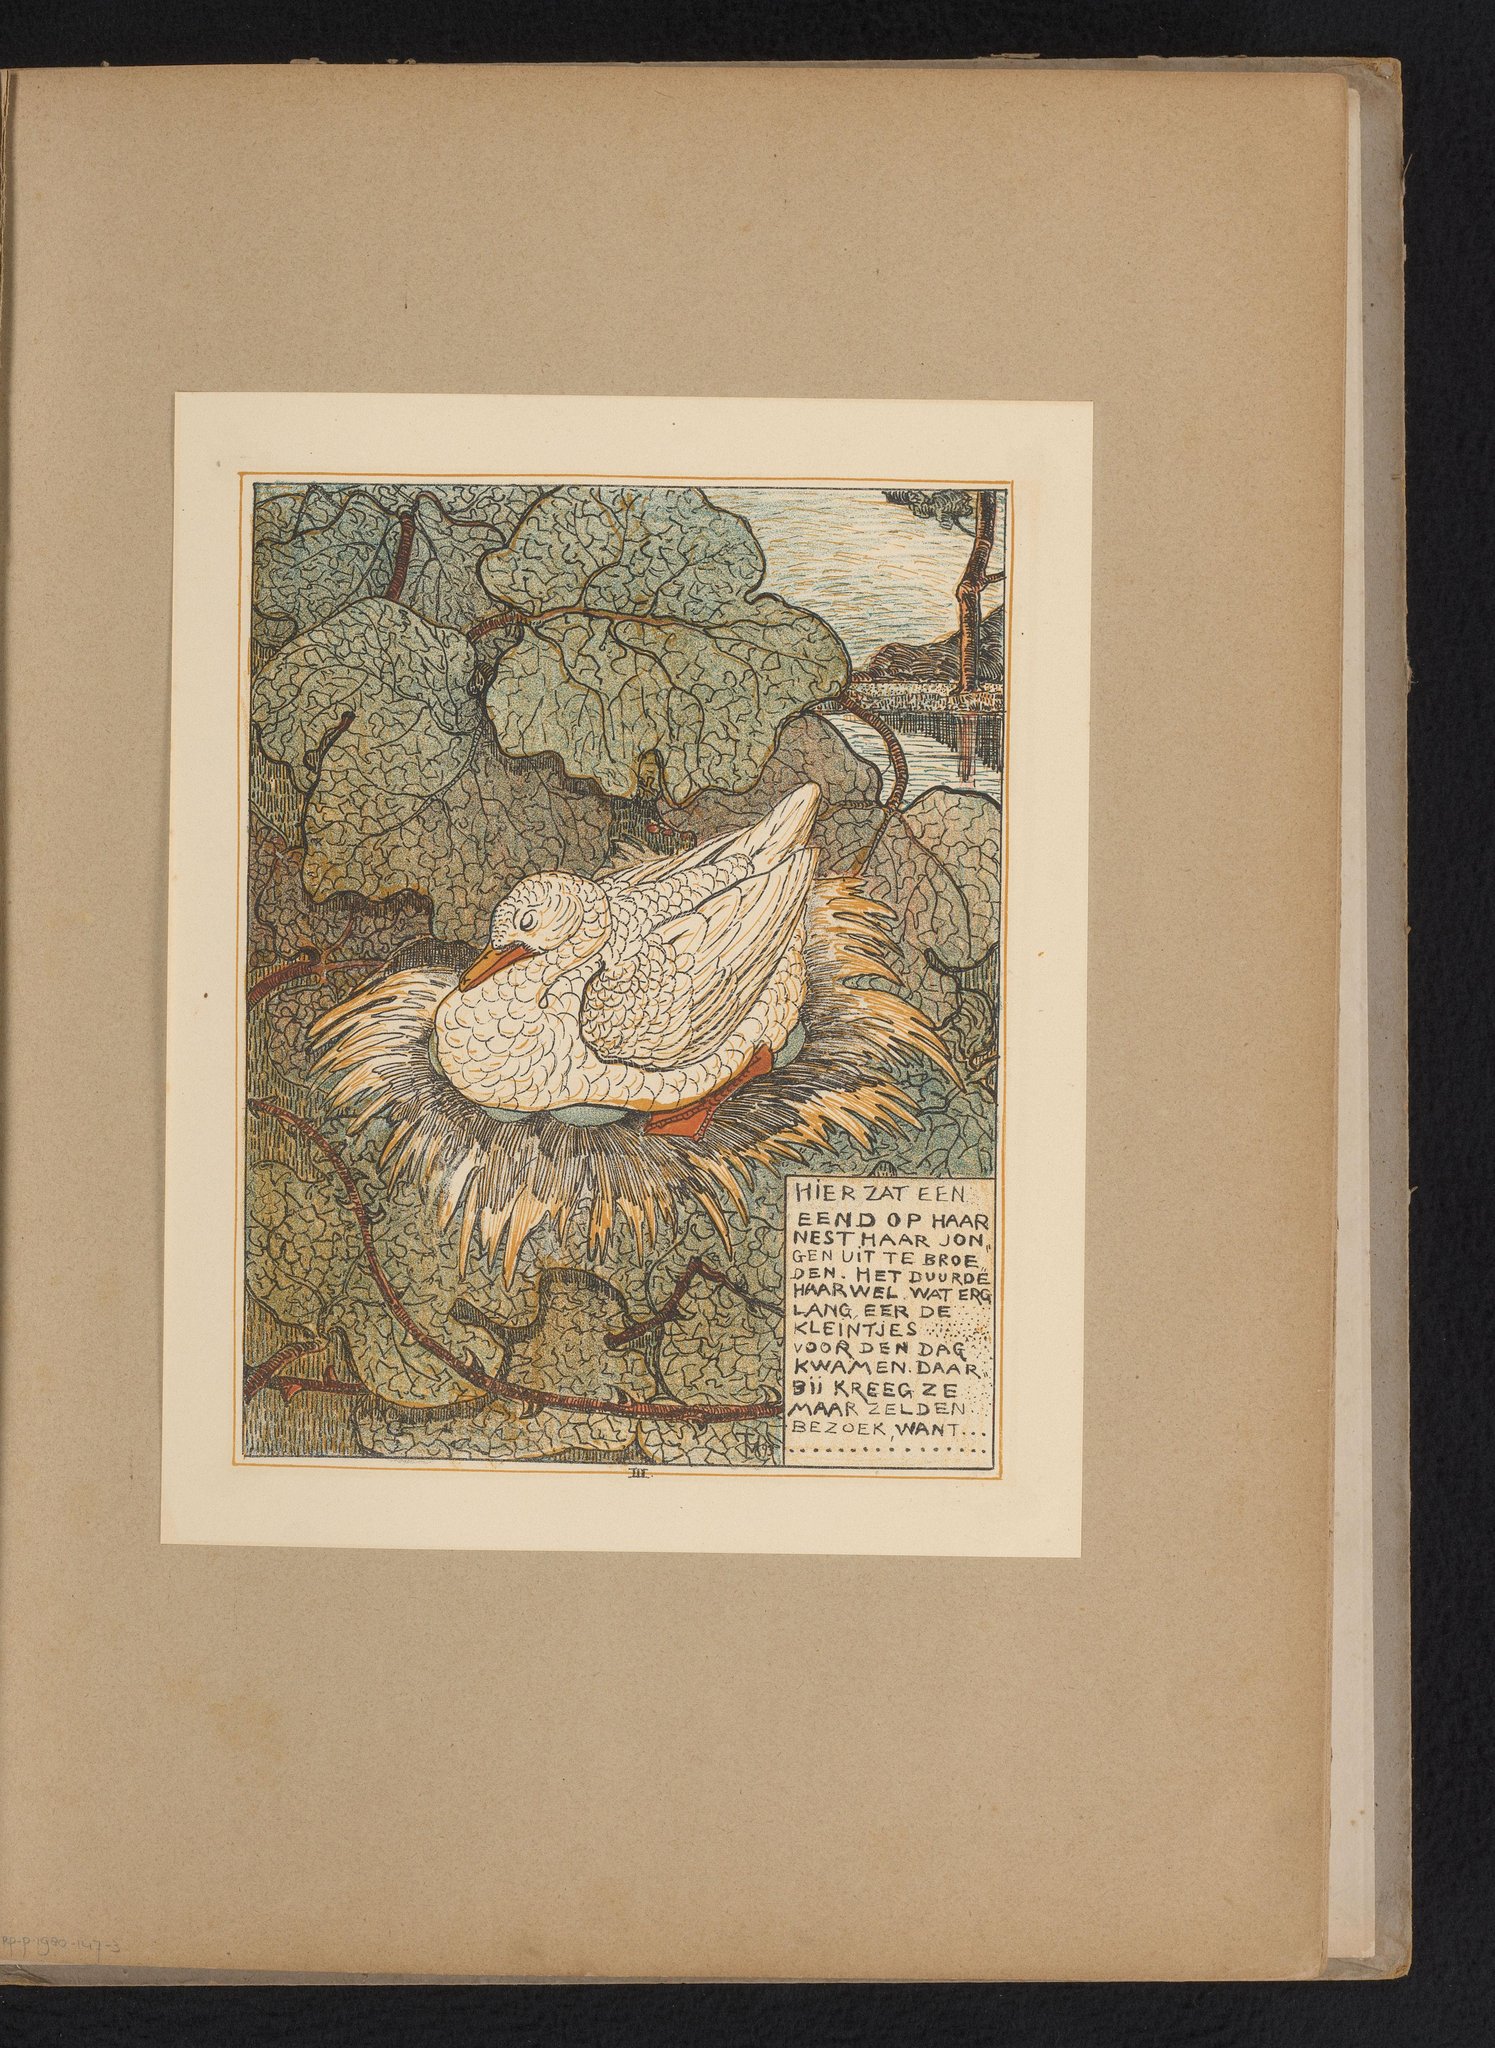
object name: print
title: Broedende eend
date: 1893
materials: paper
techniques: lithograph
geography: the hague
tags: water-birds: duck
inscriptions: date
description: Deze prent maakt deel uit van een album.